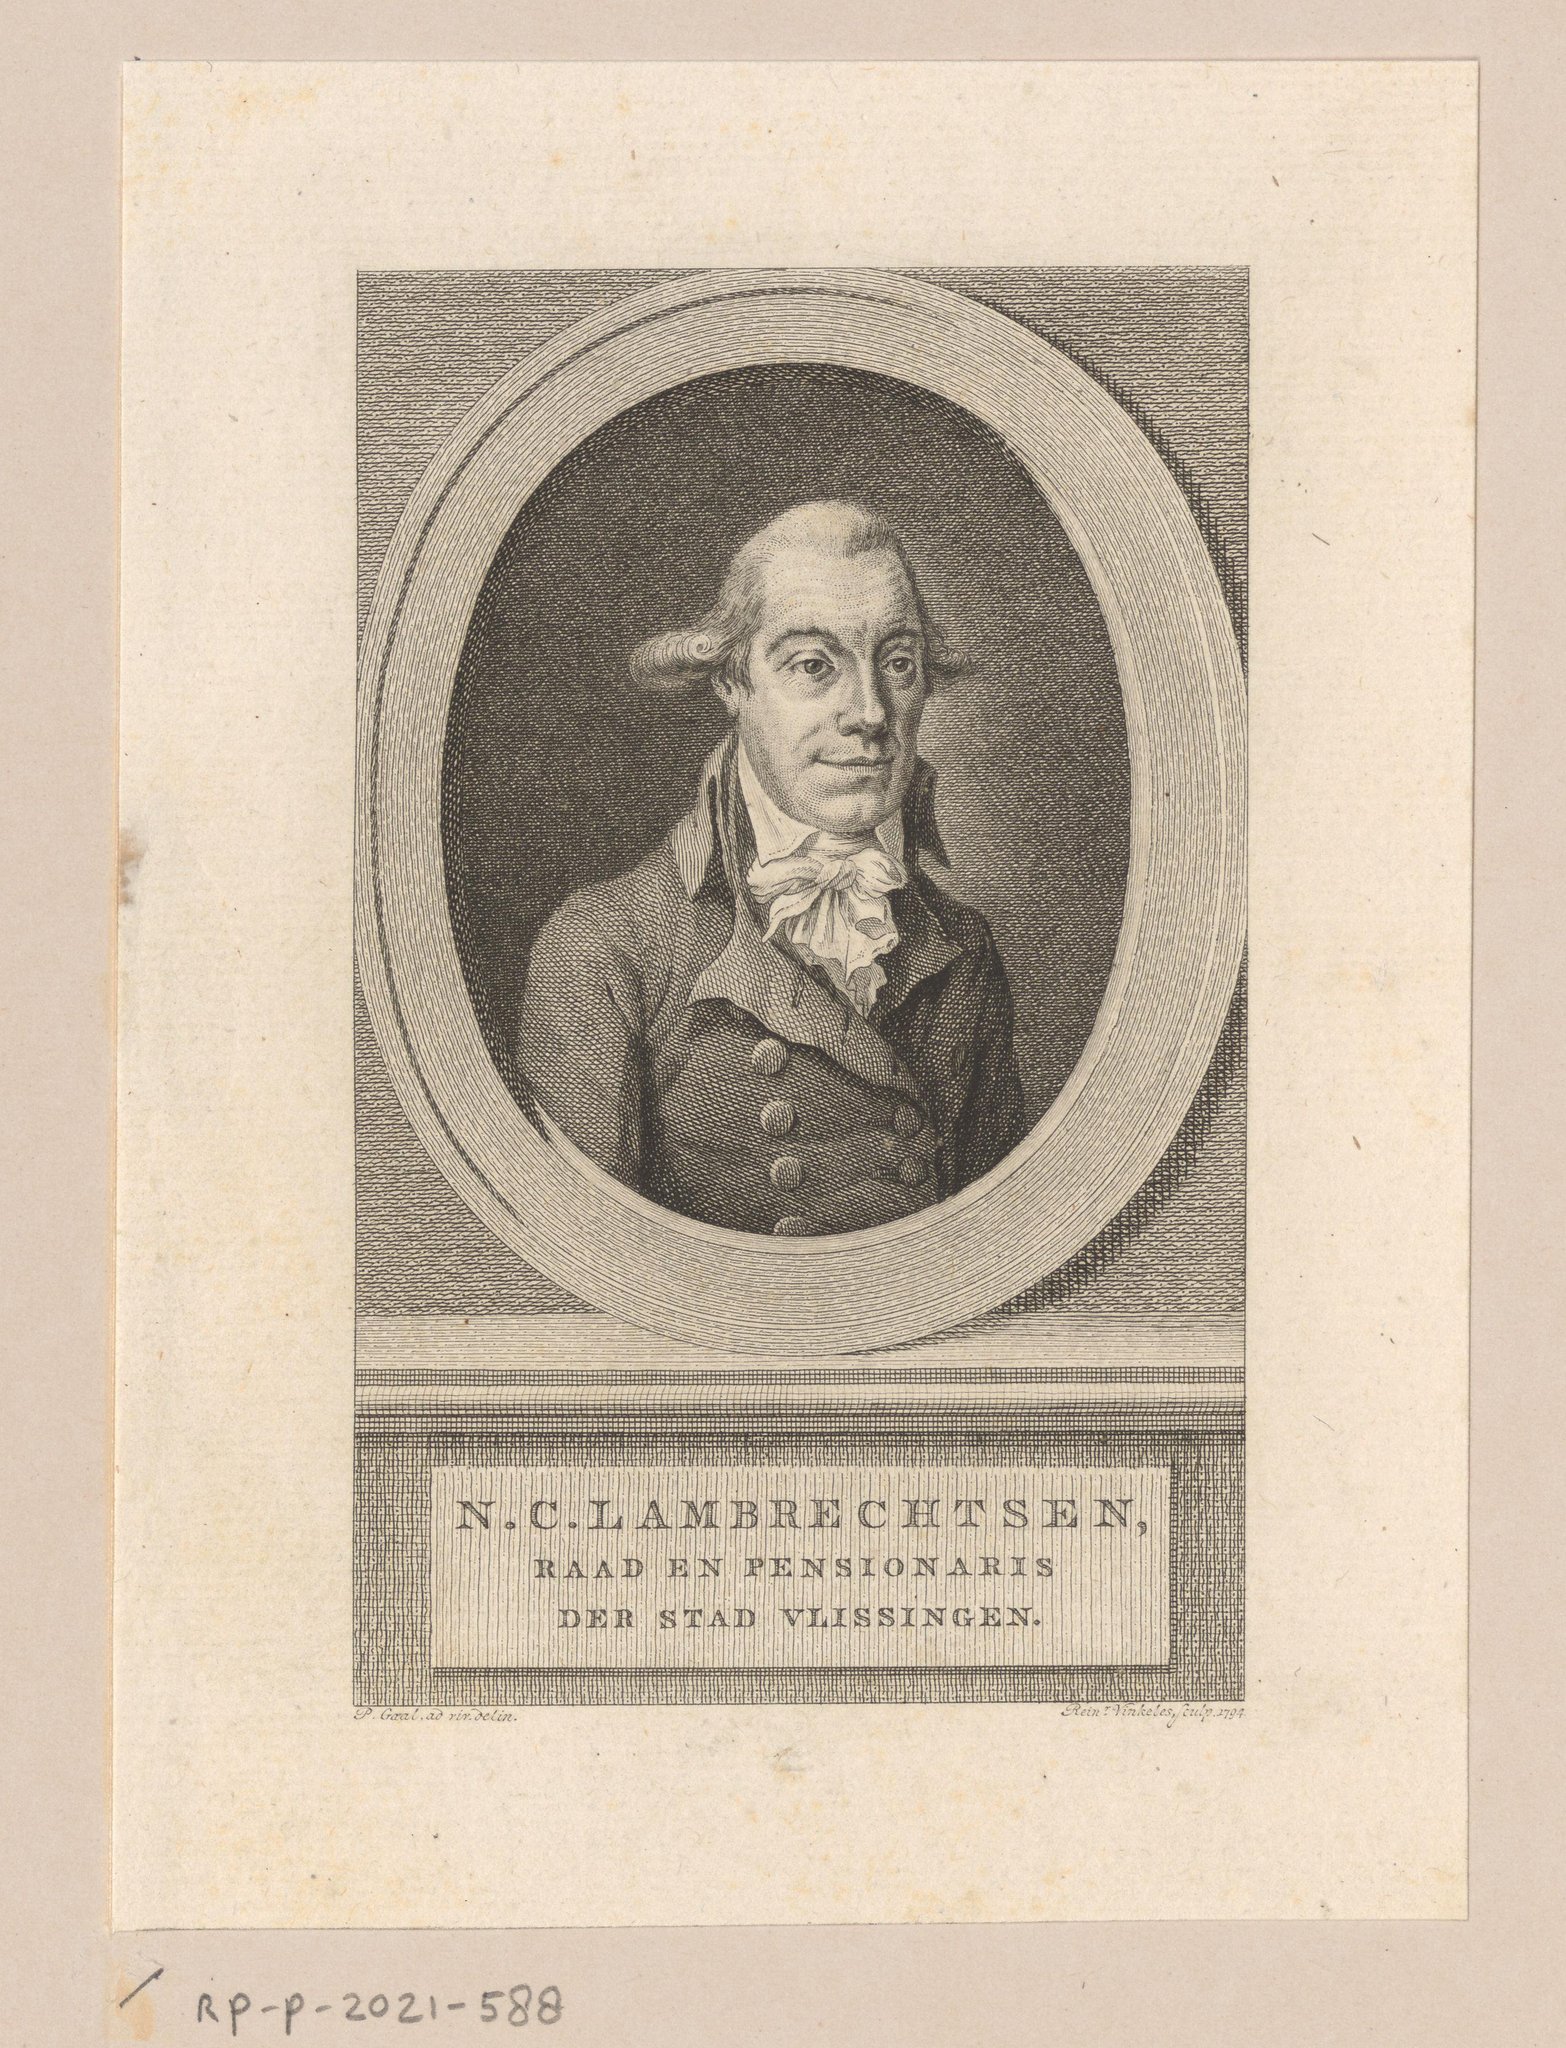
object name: book illustration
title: Portret van Nicolaas Cornelis Lambrechtsen van Ritthem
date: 1794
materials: paper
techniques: etching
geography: amsterdam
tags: flushing, historical persons, politician, e.g. party leader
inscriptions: date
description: Prent waarschijnlijk uit een deel van: Wagenaar, Jan. Vaderlandsche historie, (...) ten vervolge van Wagenaars Vaderlandsche historie. Amsterdam: Johannes Allart, na 1794-1809.